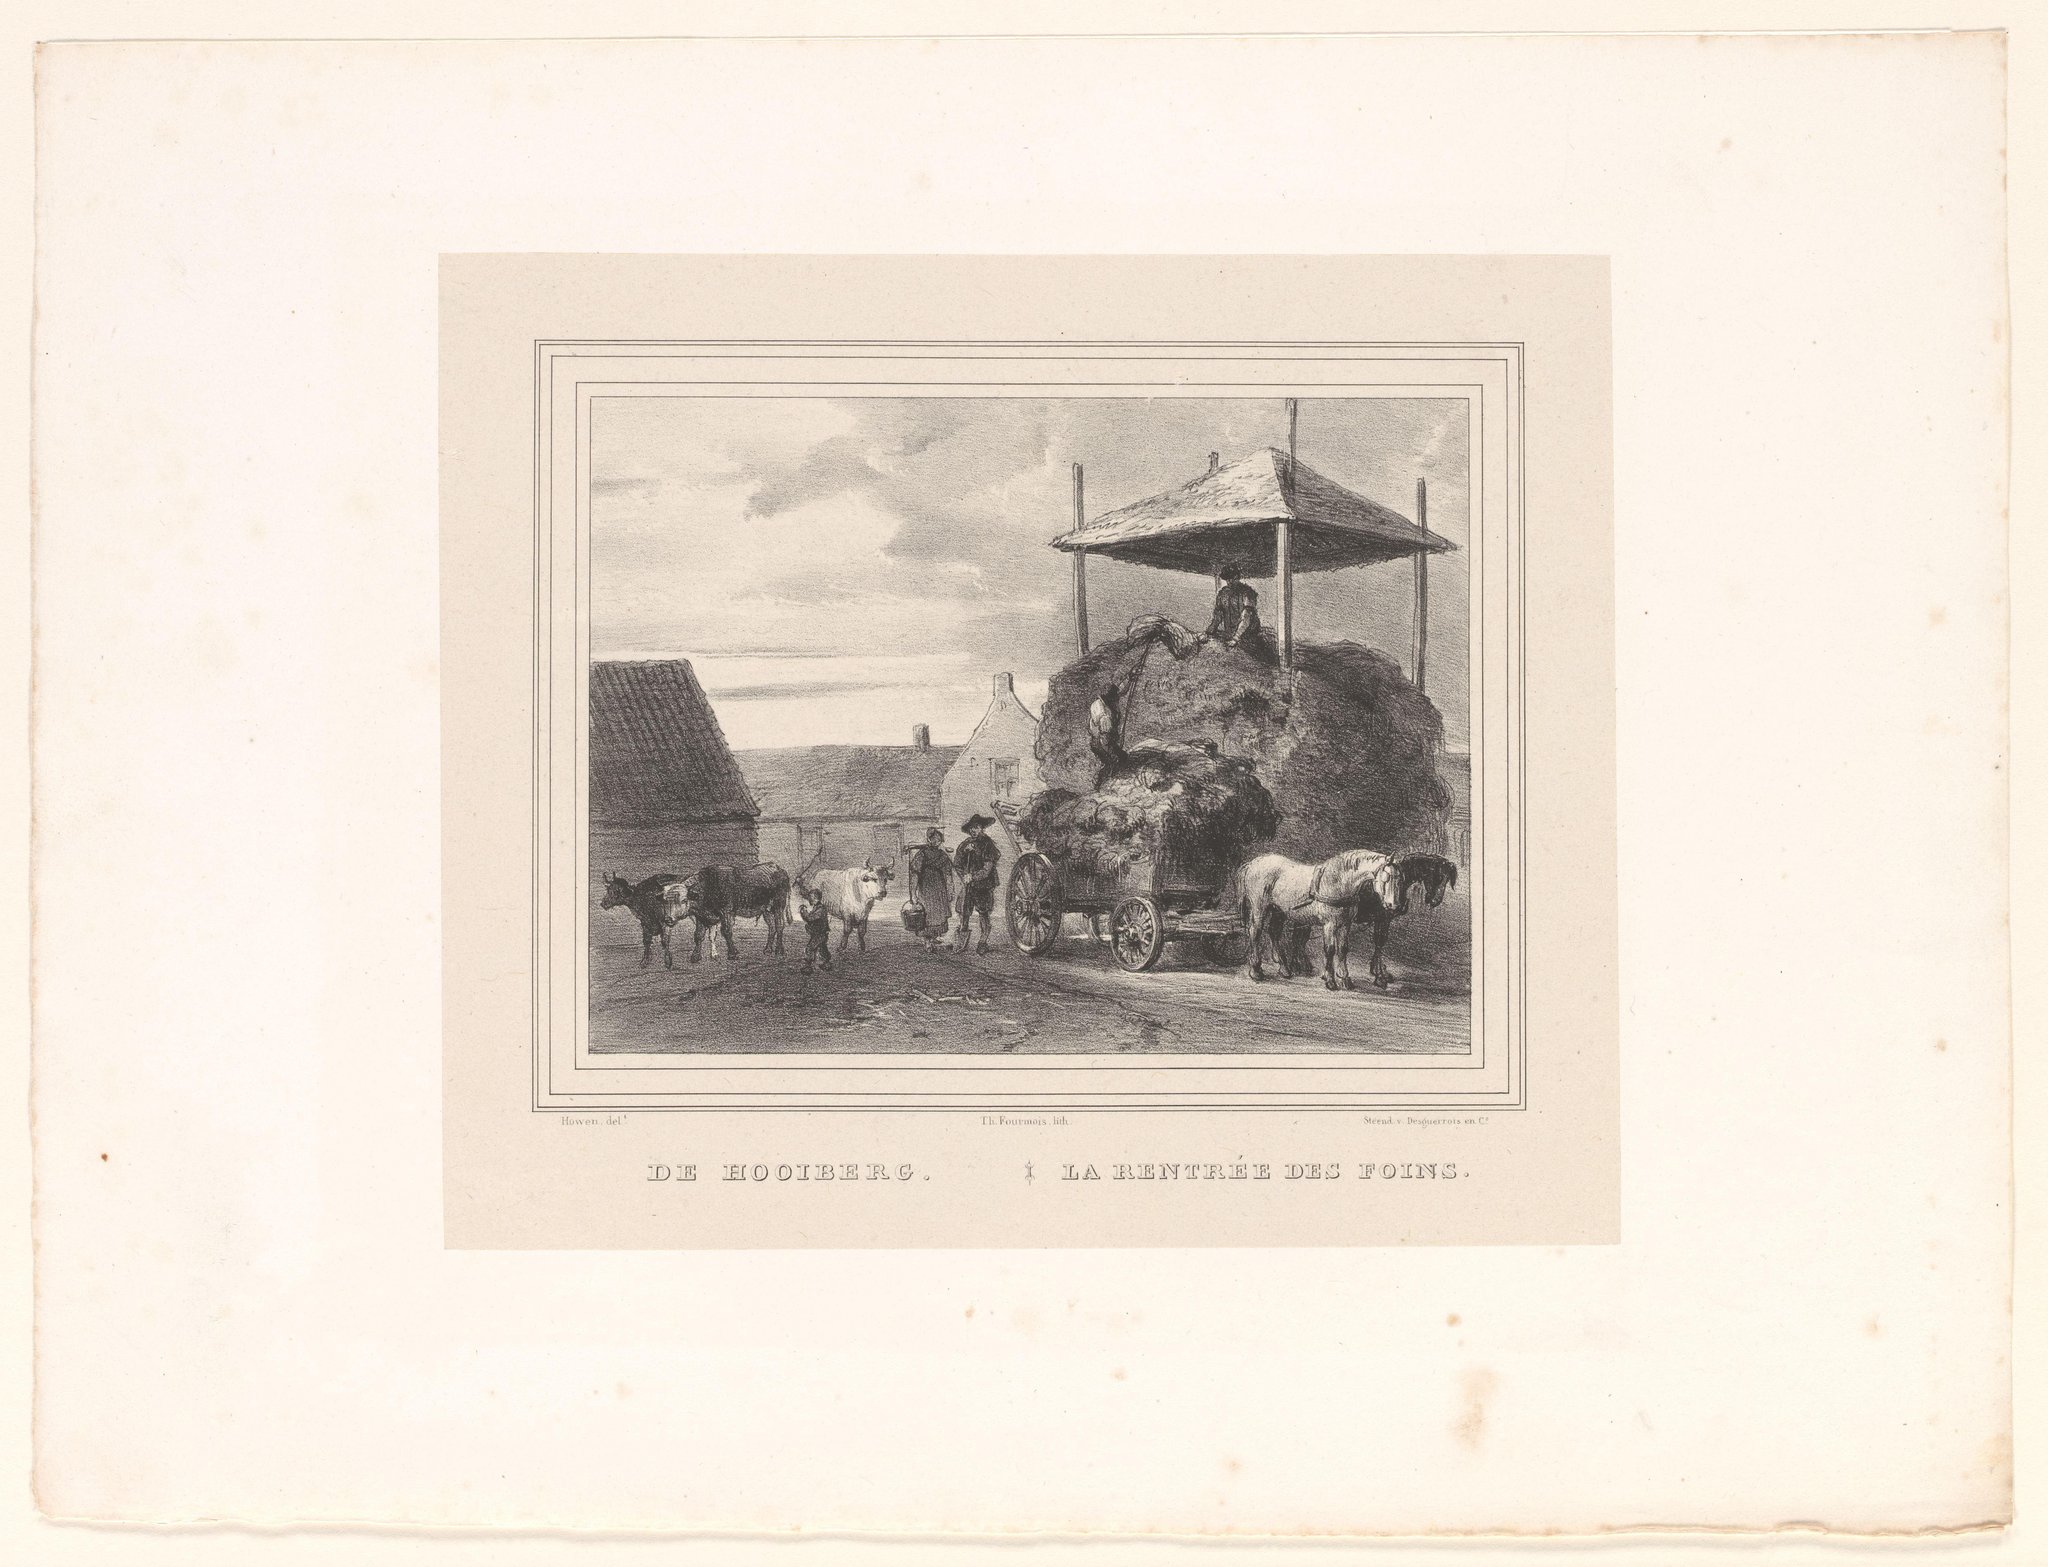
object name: print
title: Hooiwagen bij een hooiberg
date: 1827-1871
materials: paper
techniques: lithograph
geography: north holland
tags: hay-stack, hay-wagon, farm (building)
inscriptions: collector's mark: Lugt 2228